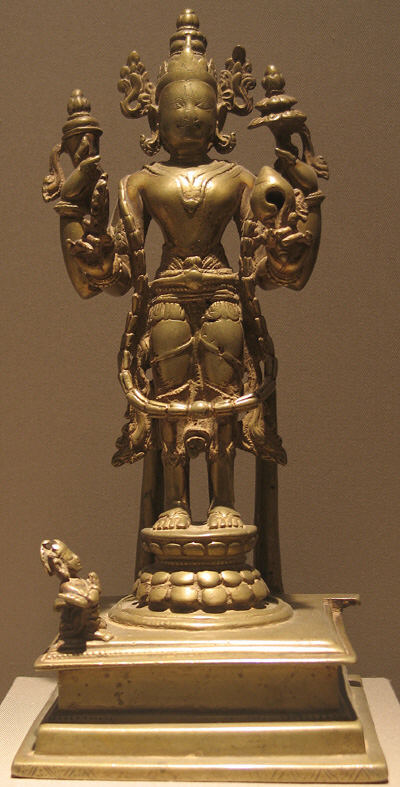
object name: figure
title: Standing Four-Armed Vishnu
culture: indian, bengal or bangladesh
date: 1201-1300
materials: brass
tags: vishnu,hinduism